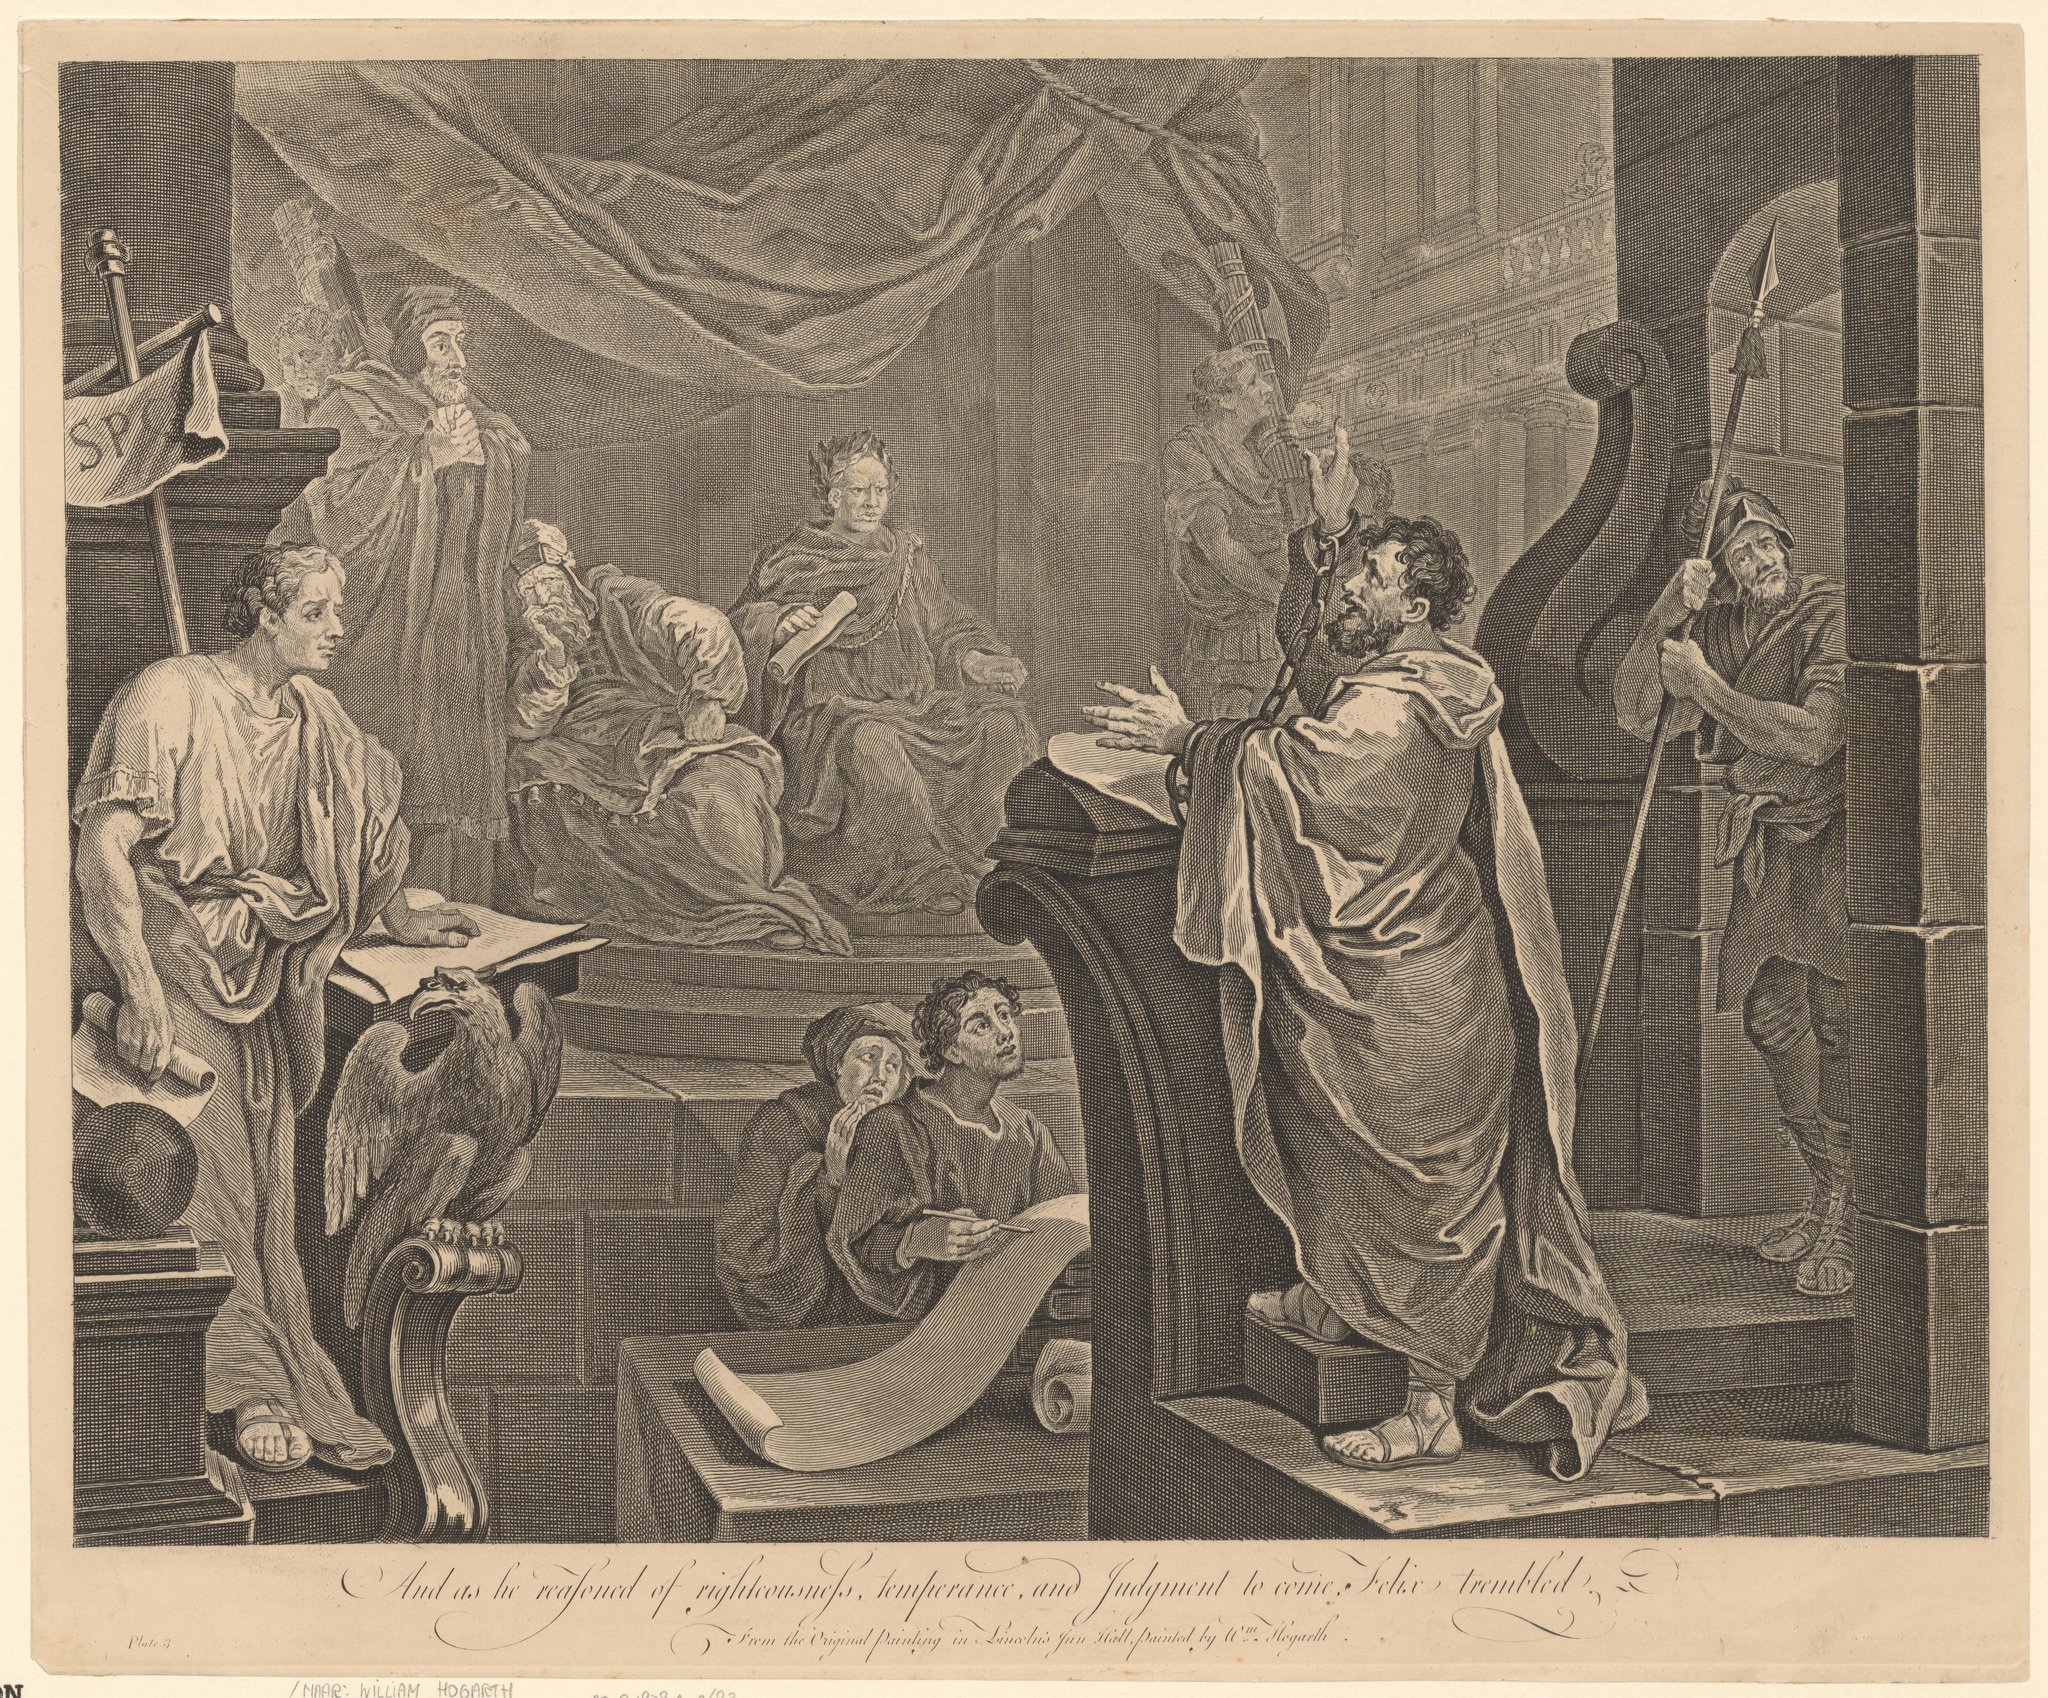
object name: print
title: Apostel Paulus door Tertullus beschuldigd voor Felix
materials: paper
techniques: engraving, etching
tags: paul accused before felix by tertullus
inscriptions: collector's mark: Lugt 2228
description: Linksonder genummerd: plate 3. Links- en rechtsonder is tekst weggeslepen.